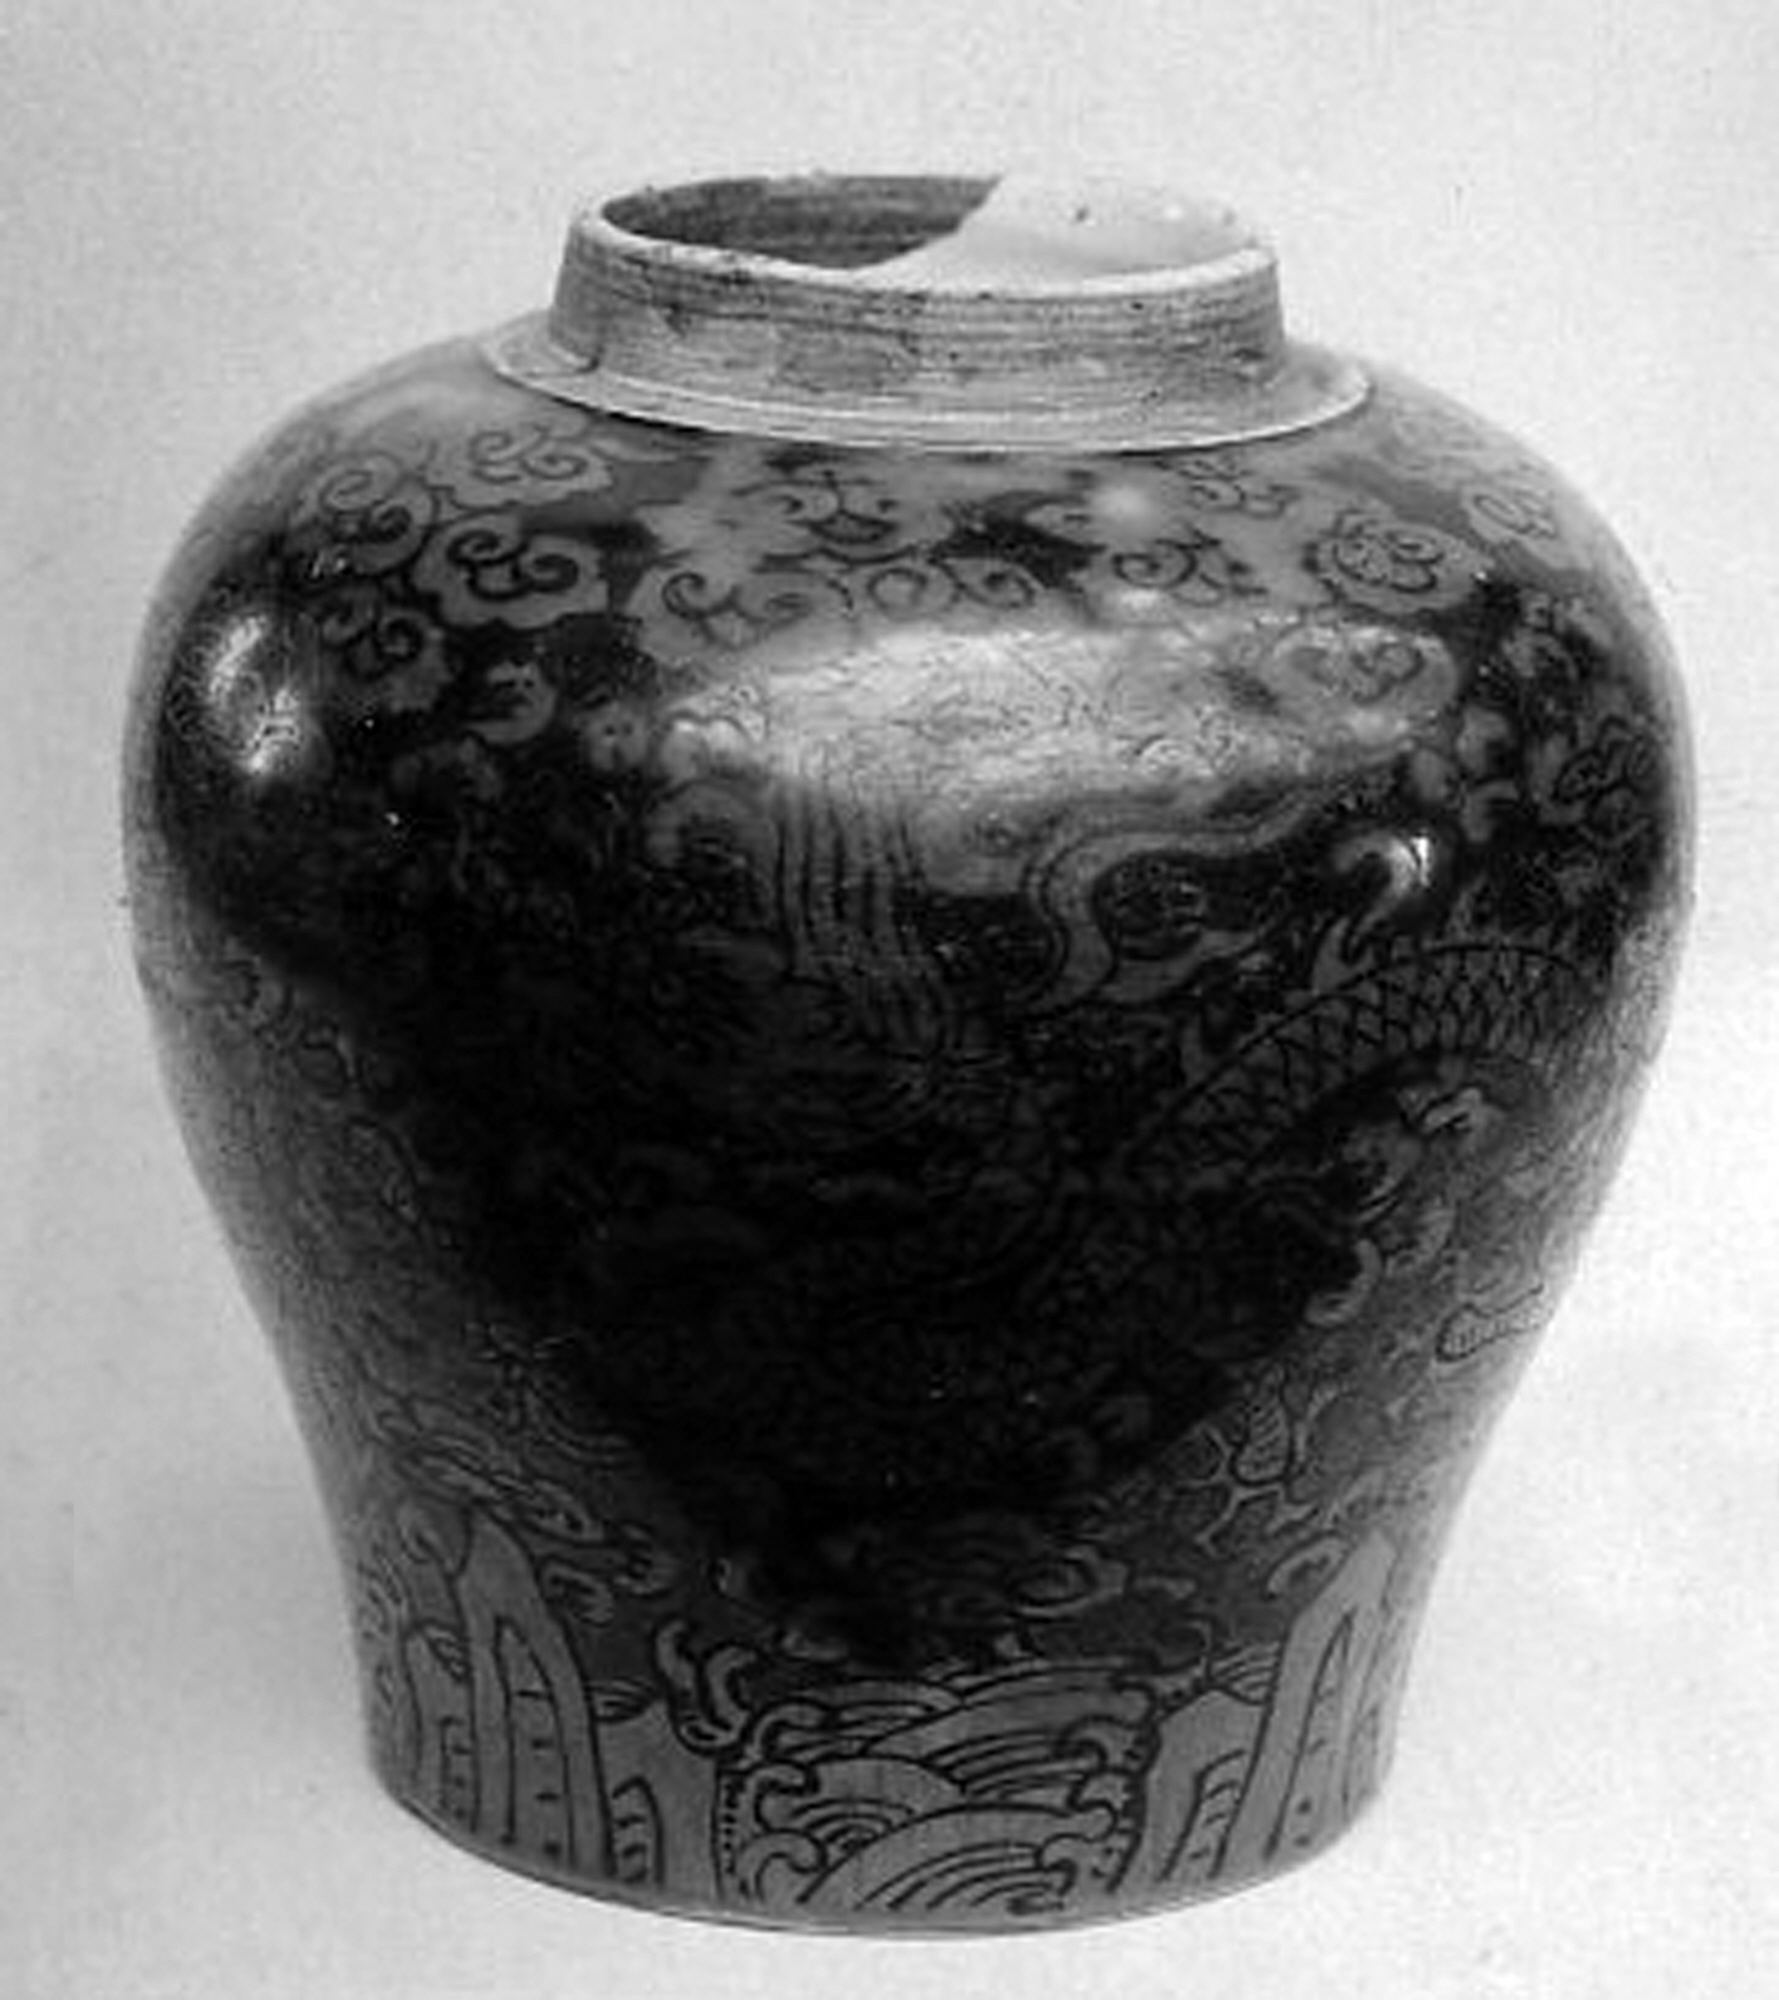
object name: jar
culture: chinese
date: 1522-1566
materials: porcelain